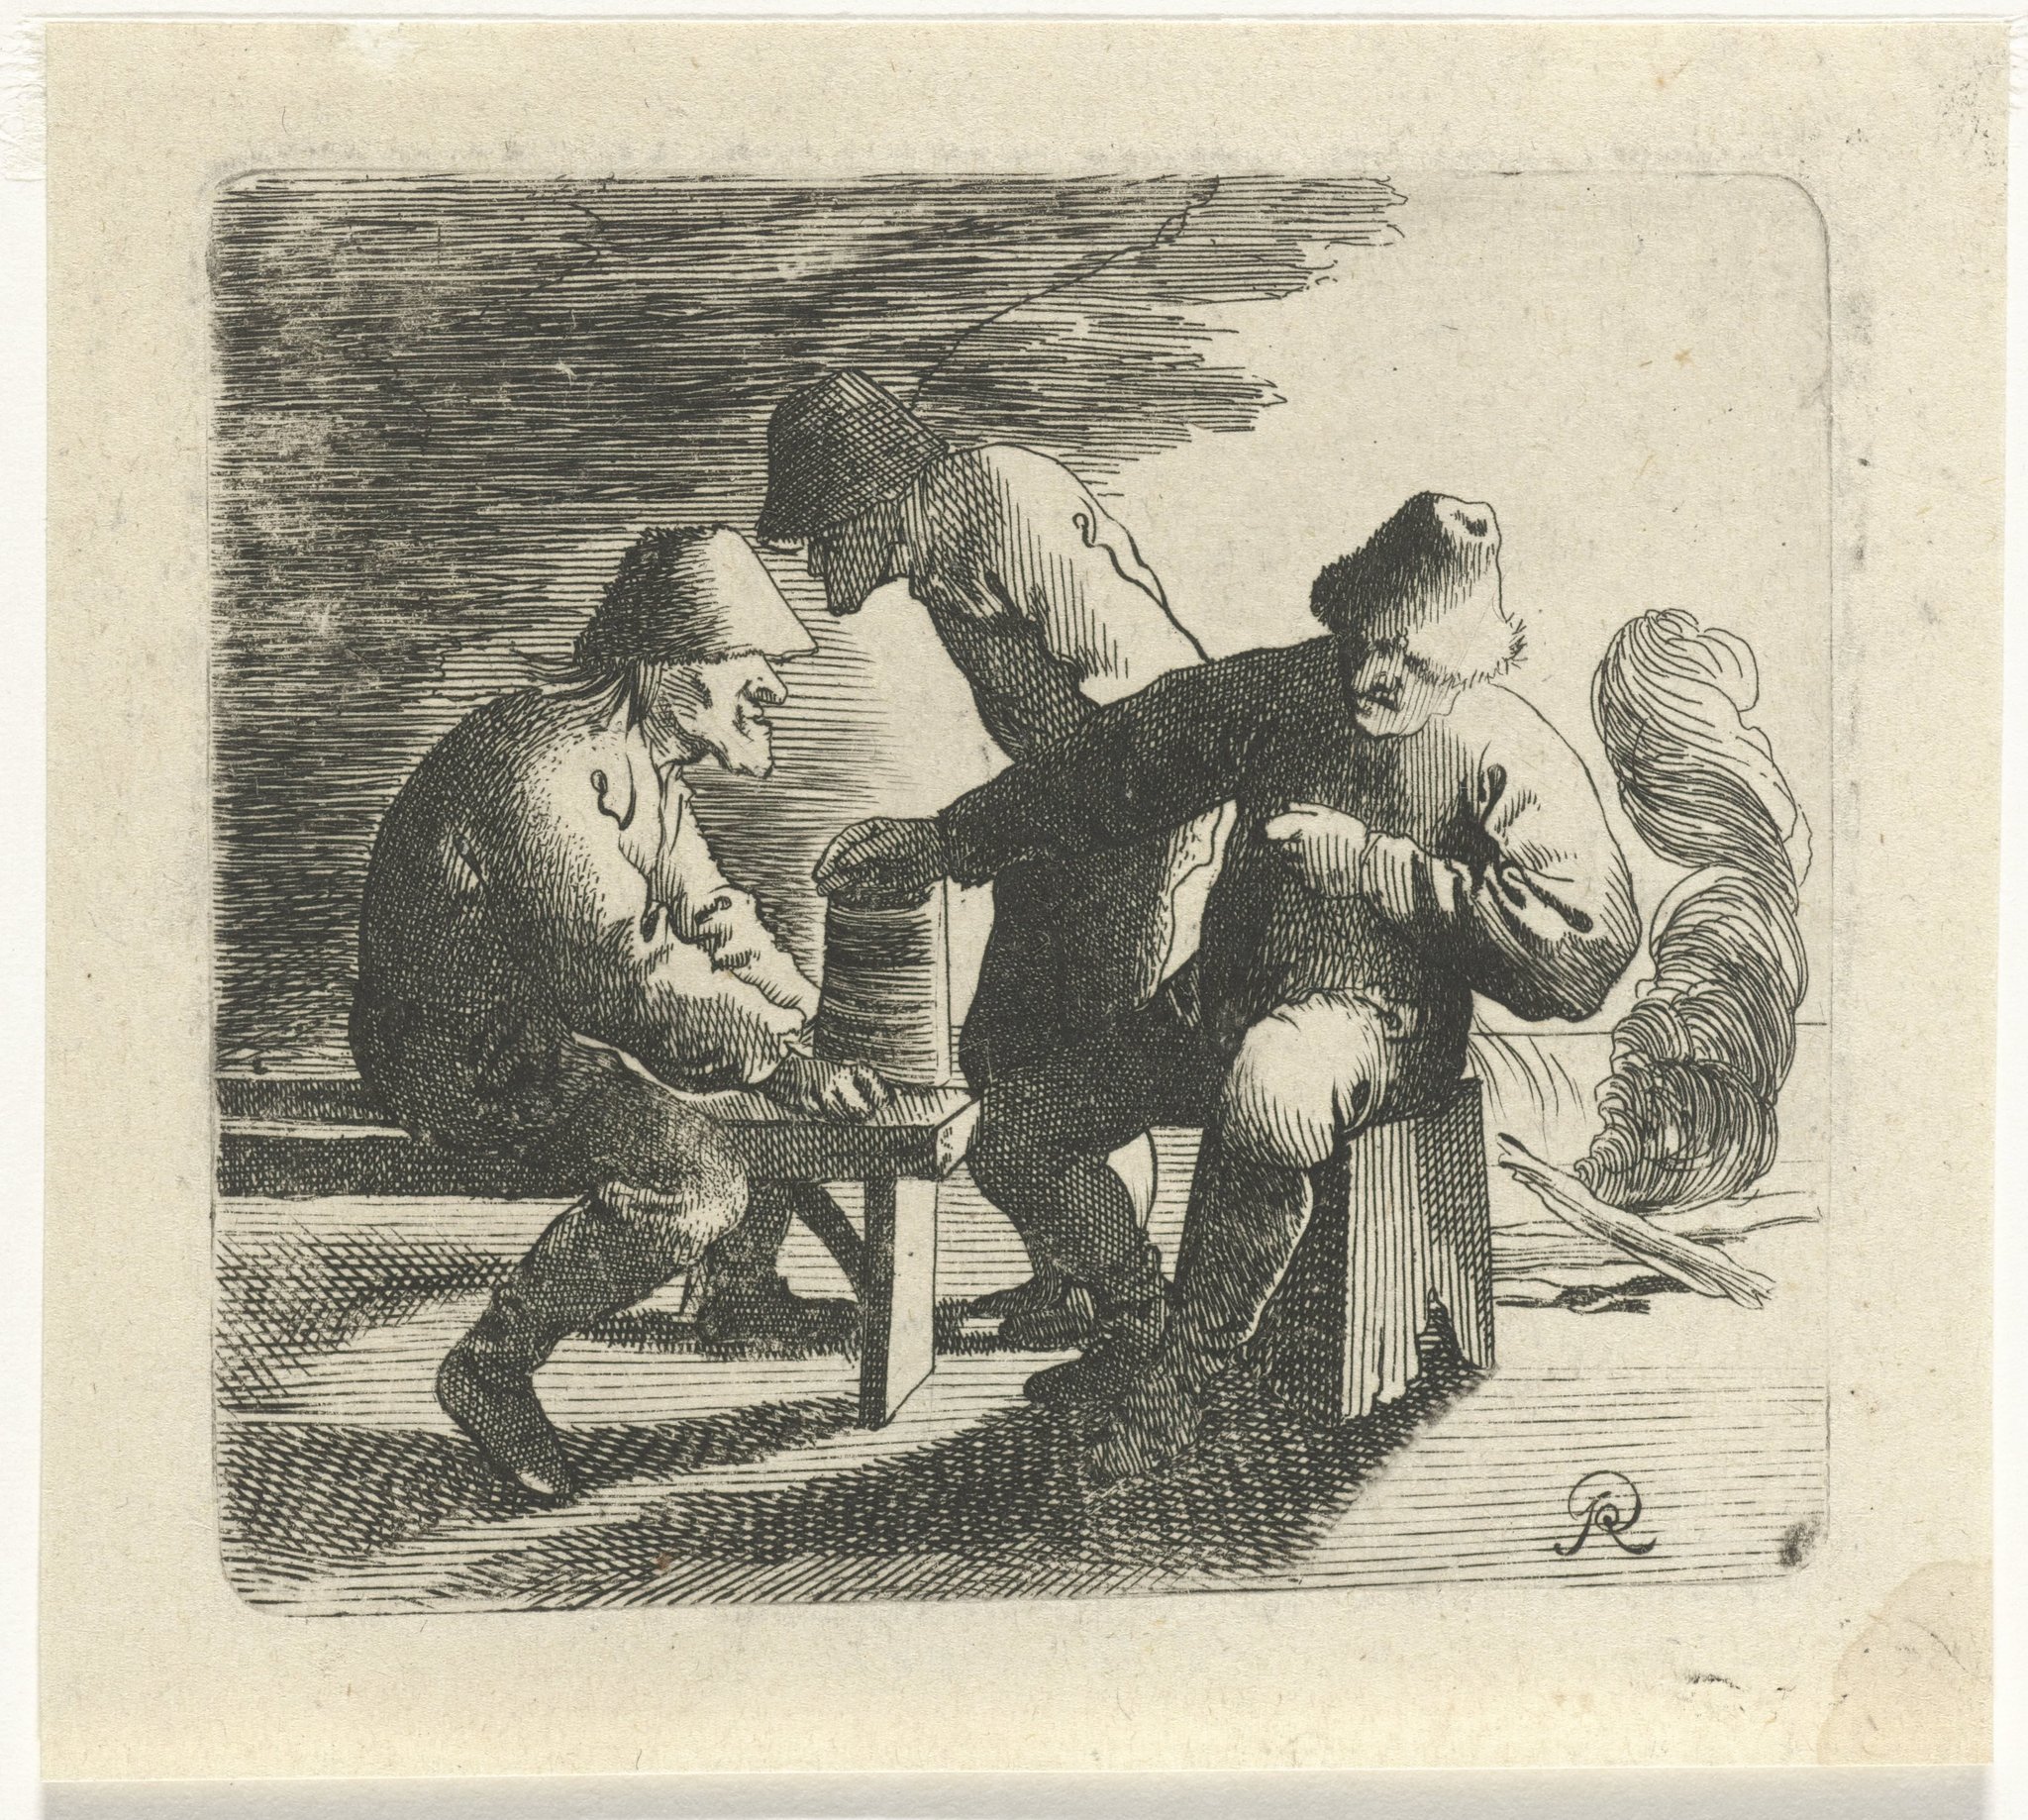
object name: print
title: Drie boeren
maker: pieter jansz quast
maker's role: draughtsman, painter, print maker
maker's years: 1605-1647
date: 1615-1647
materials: paper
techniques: engraving, etching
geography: netherlands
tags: farmers, camp-fire; watch-fire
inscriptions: collector's mark: Lugt 2228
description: Drie boeren in een interieur bij een houten bank, waarvan er twee een spel spelen. Rechts een vuurtje.